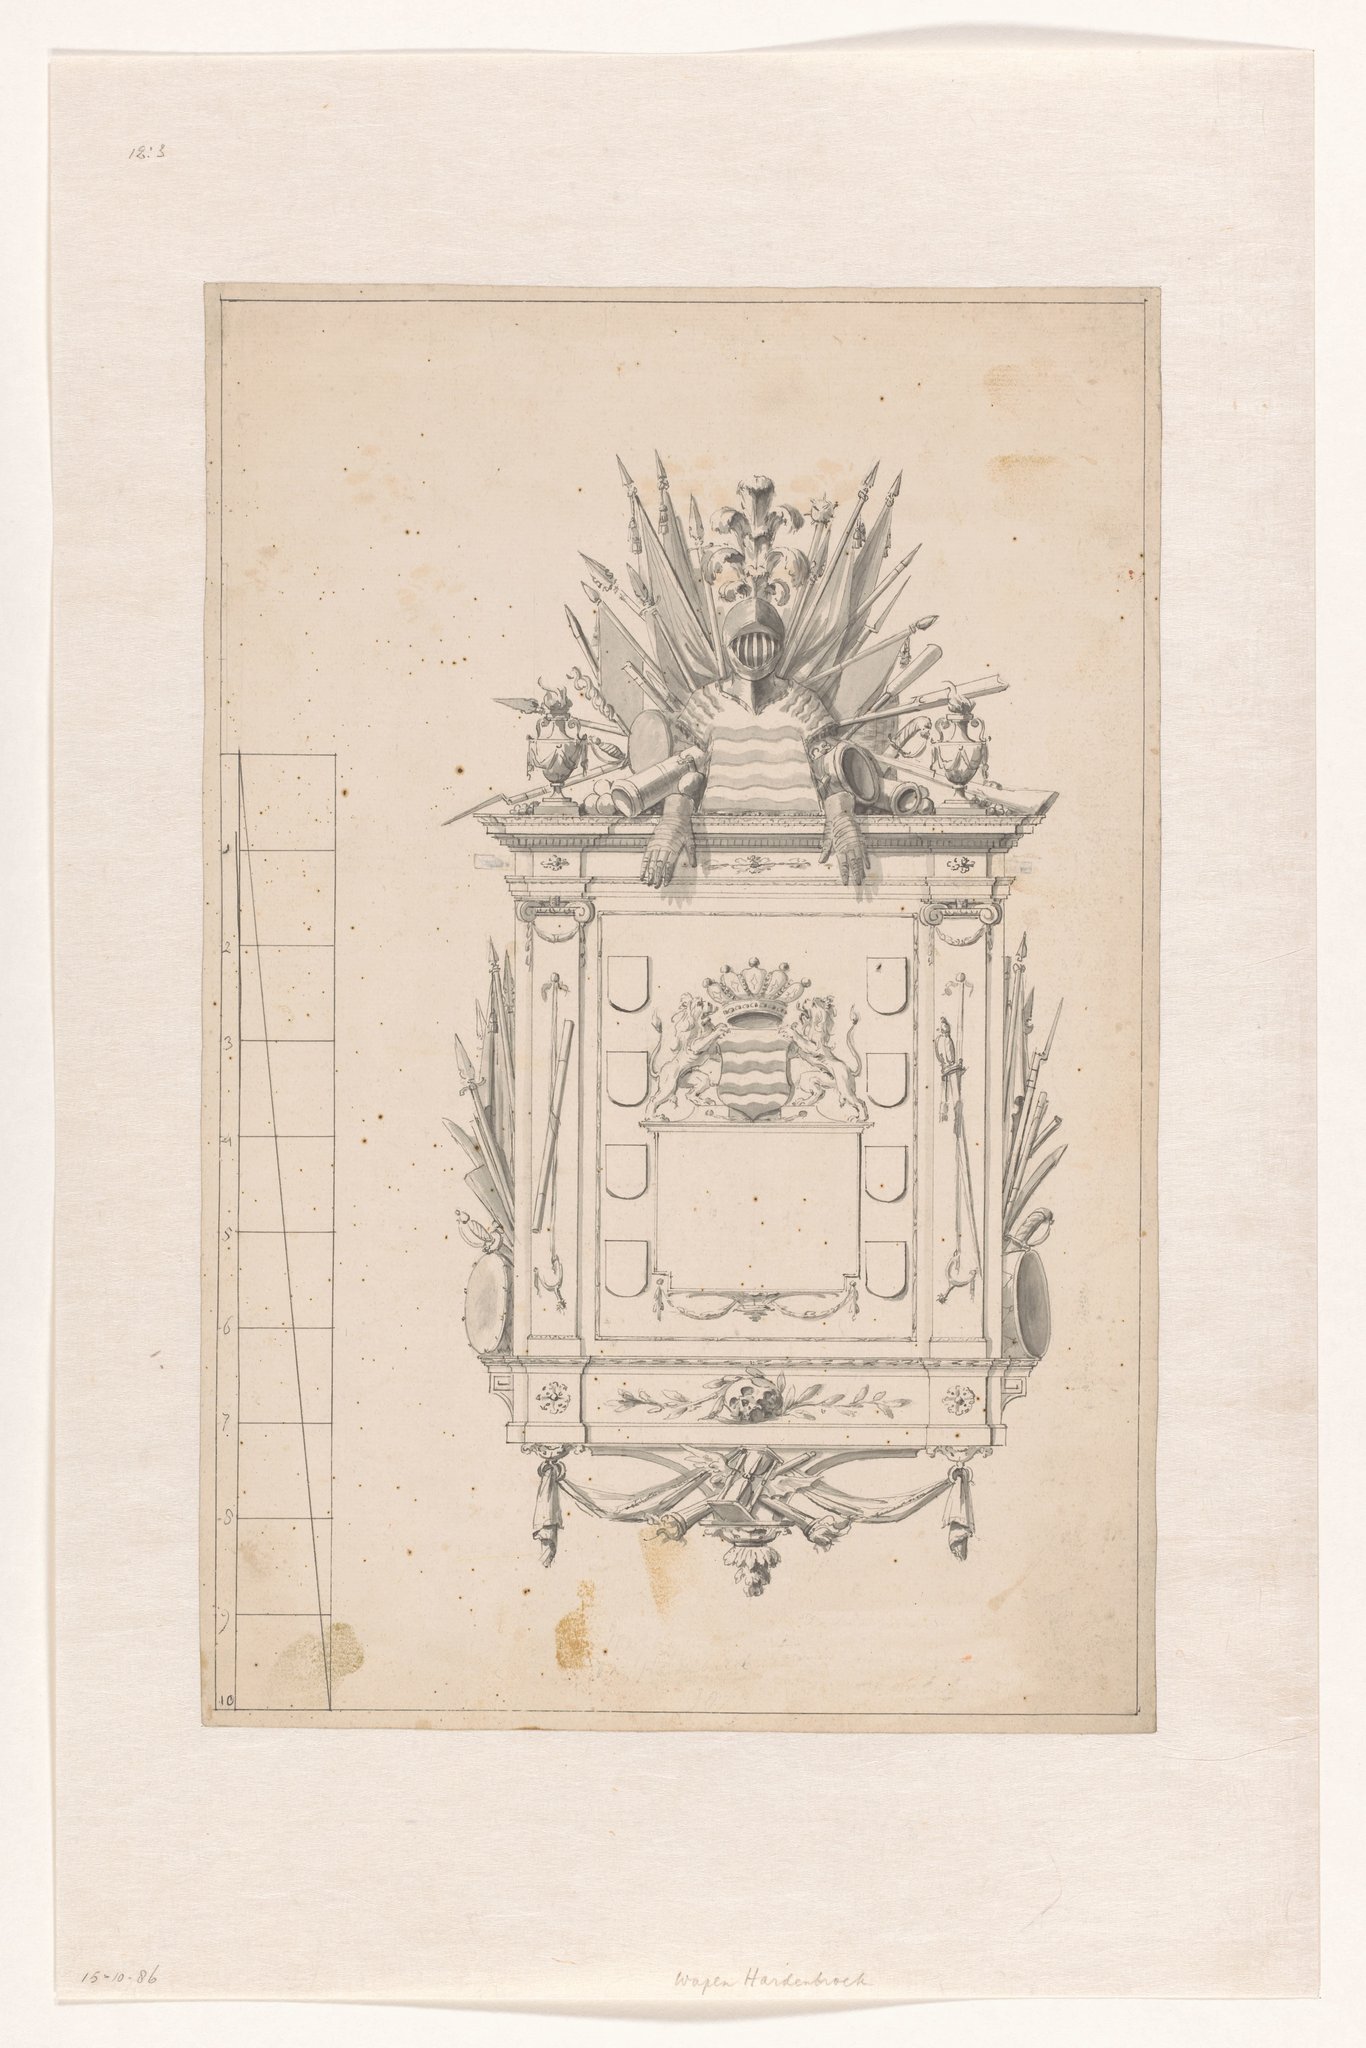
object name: design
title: Ontwerp voor een rouwbord met het wapen van Hardenbroek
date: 1672-1752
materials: ink, paper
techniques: brush, pen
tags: coat of arms (as symbol of the state, etc.) (+ city; municipal), other memorial structures, grave, tomb and other grave-forms and grave-markers